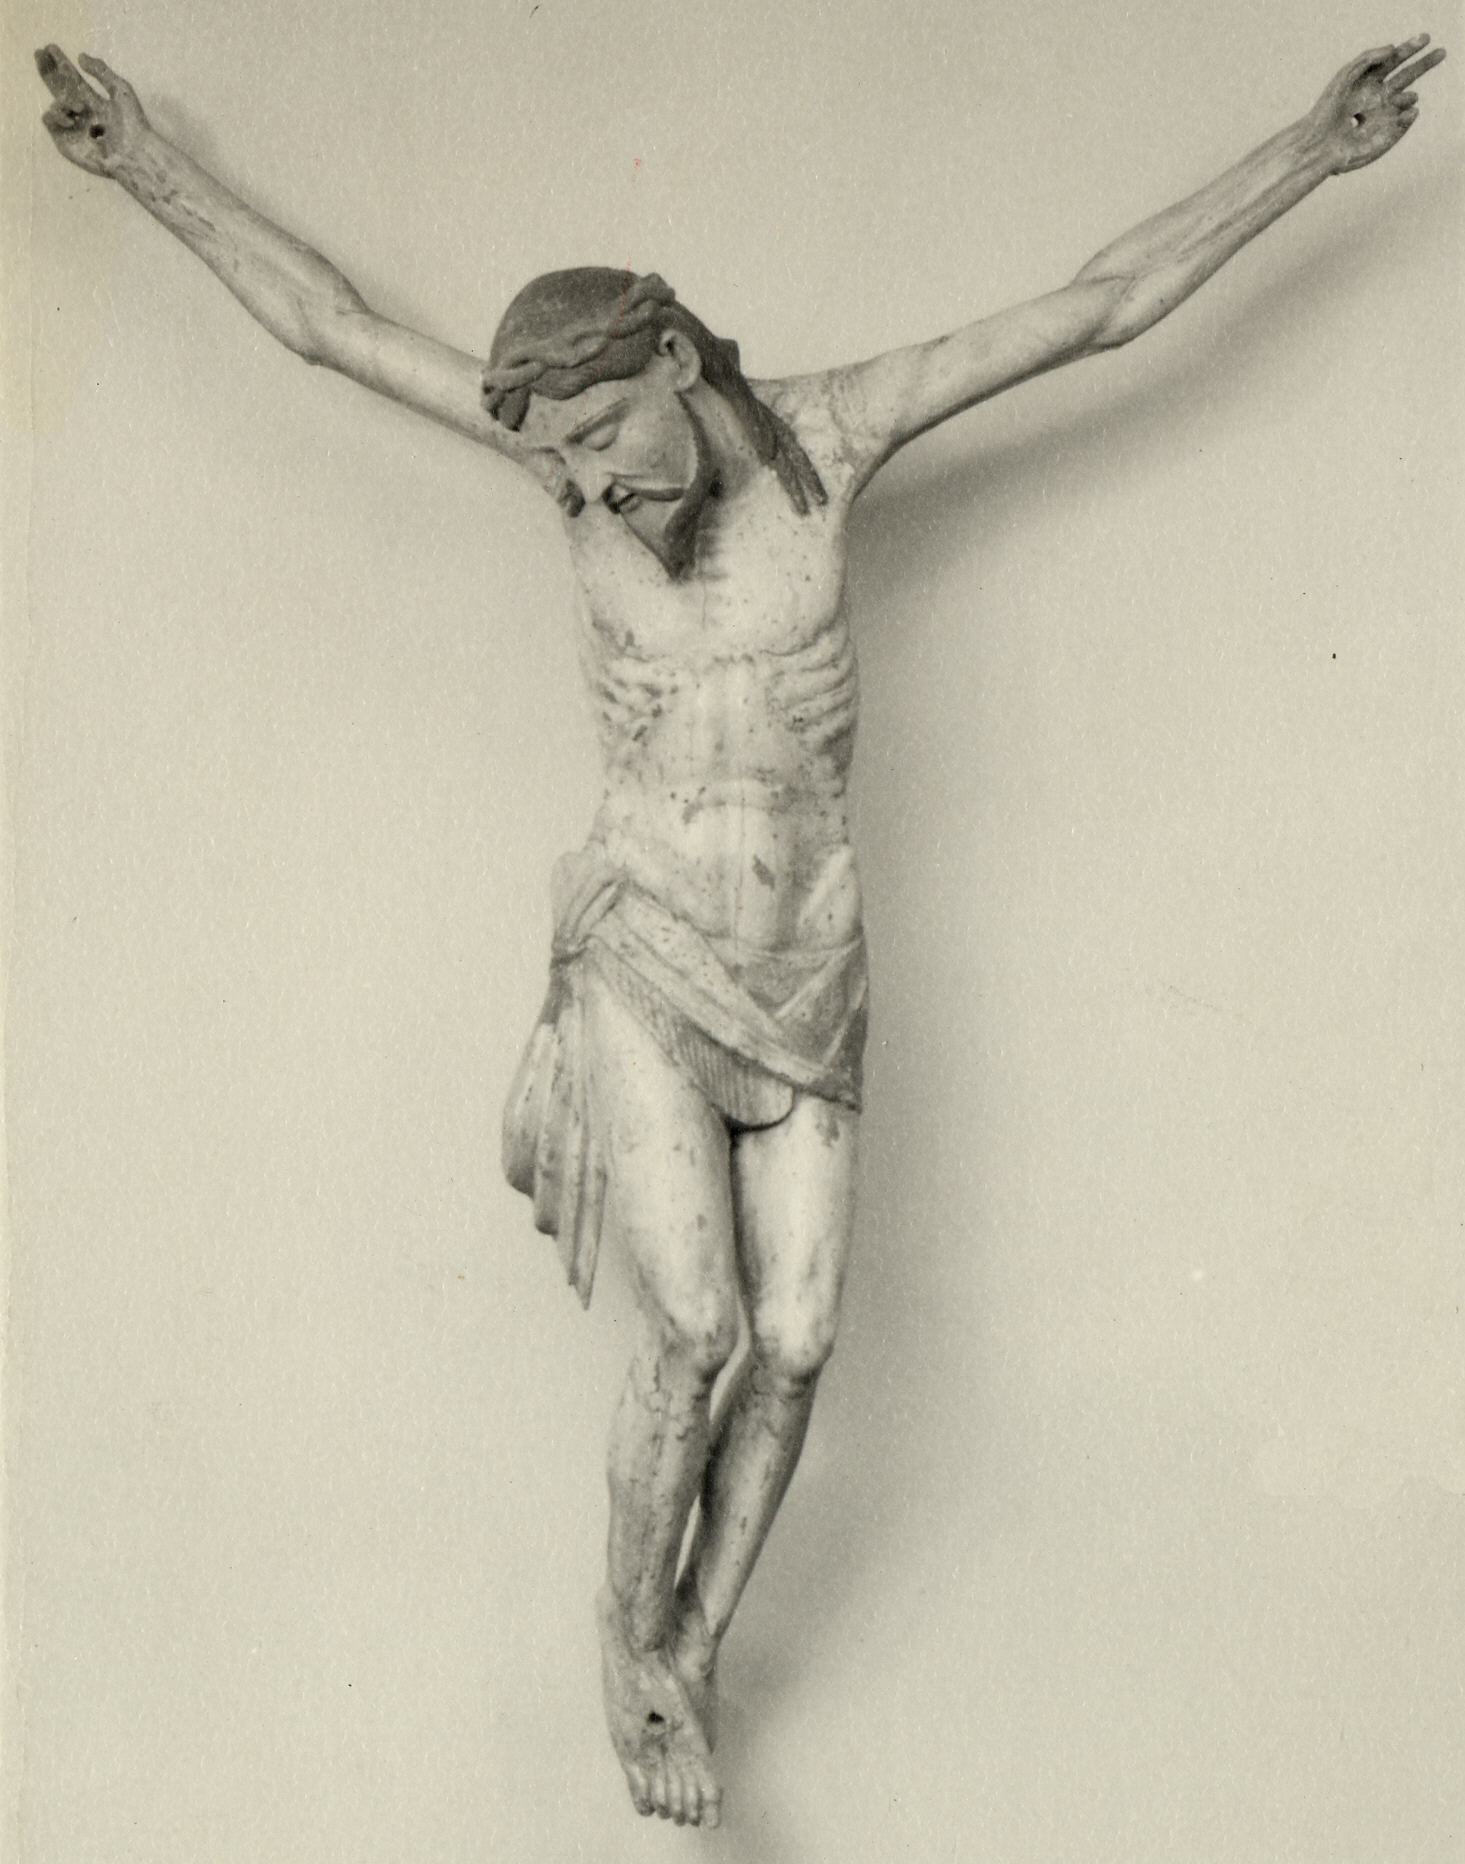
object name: statue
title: Christ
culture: italian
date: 1401-1600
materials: paint, wood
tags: christ